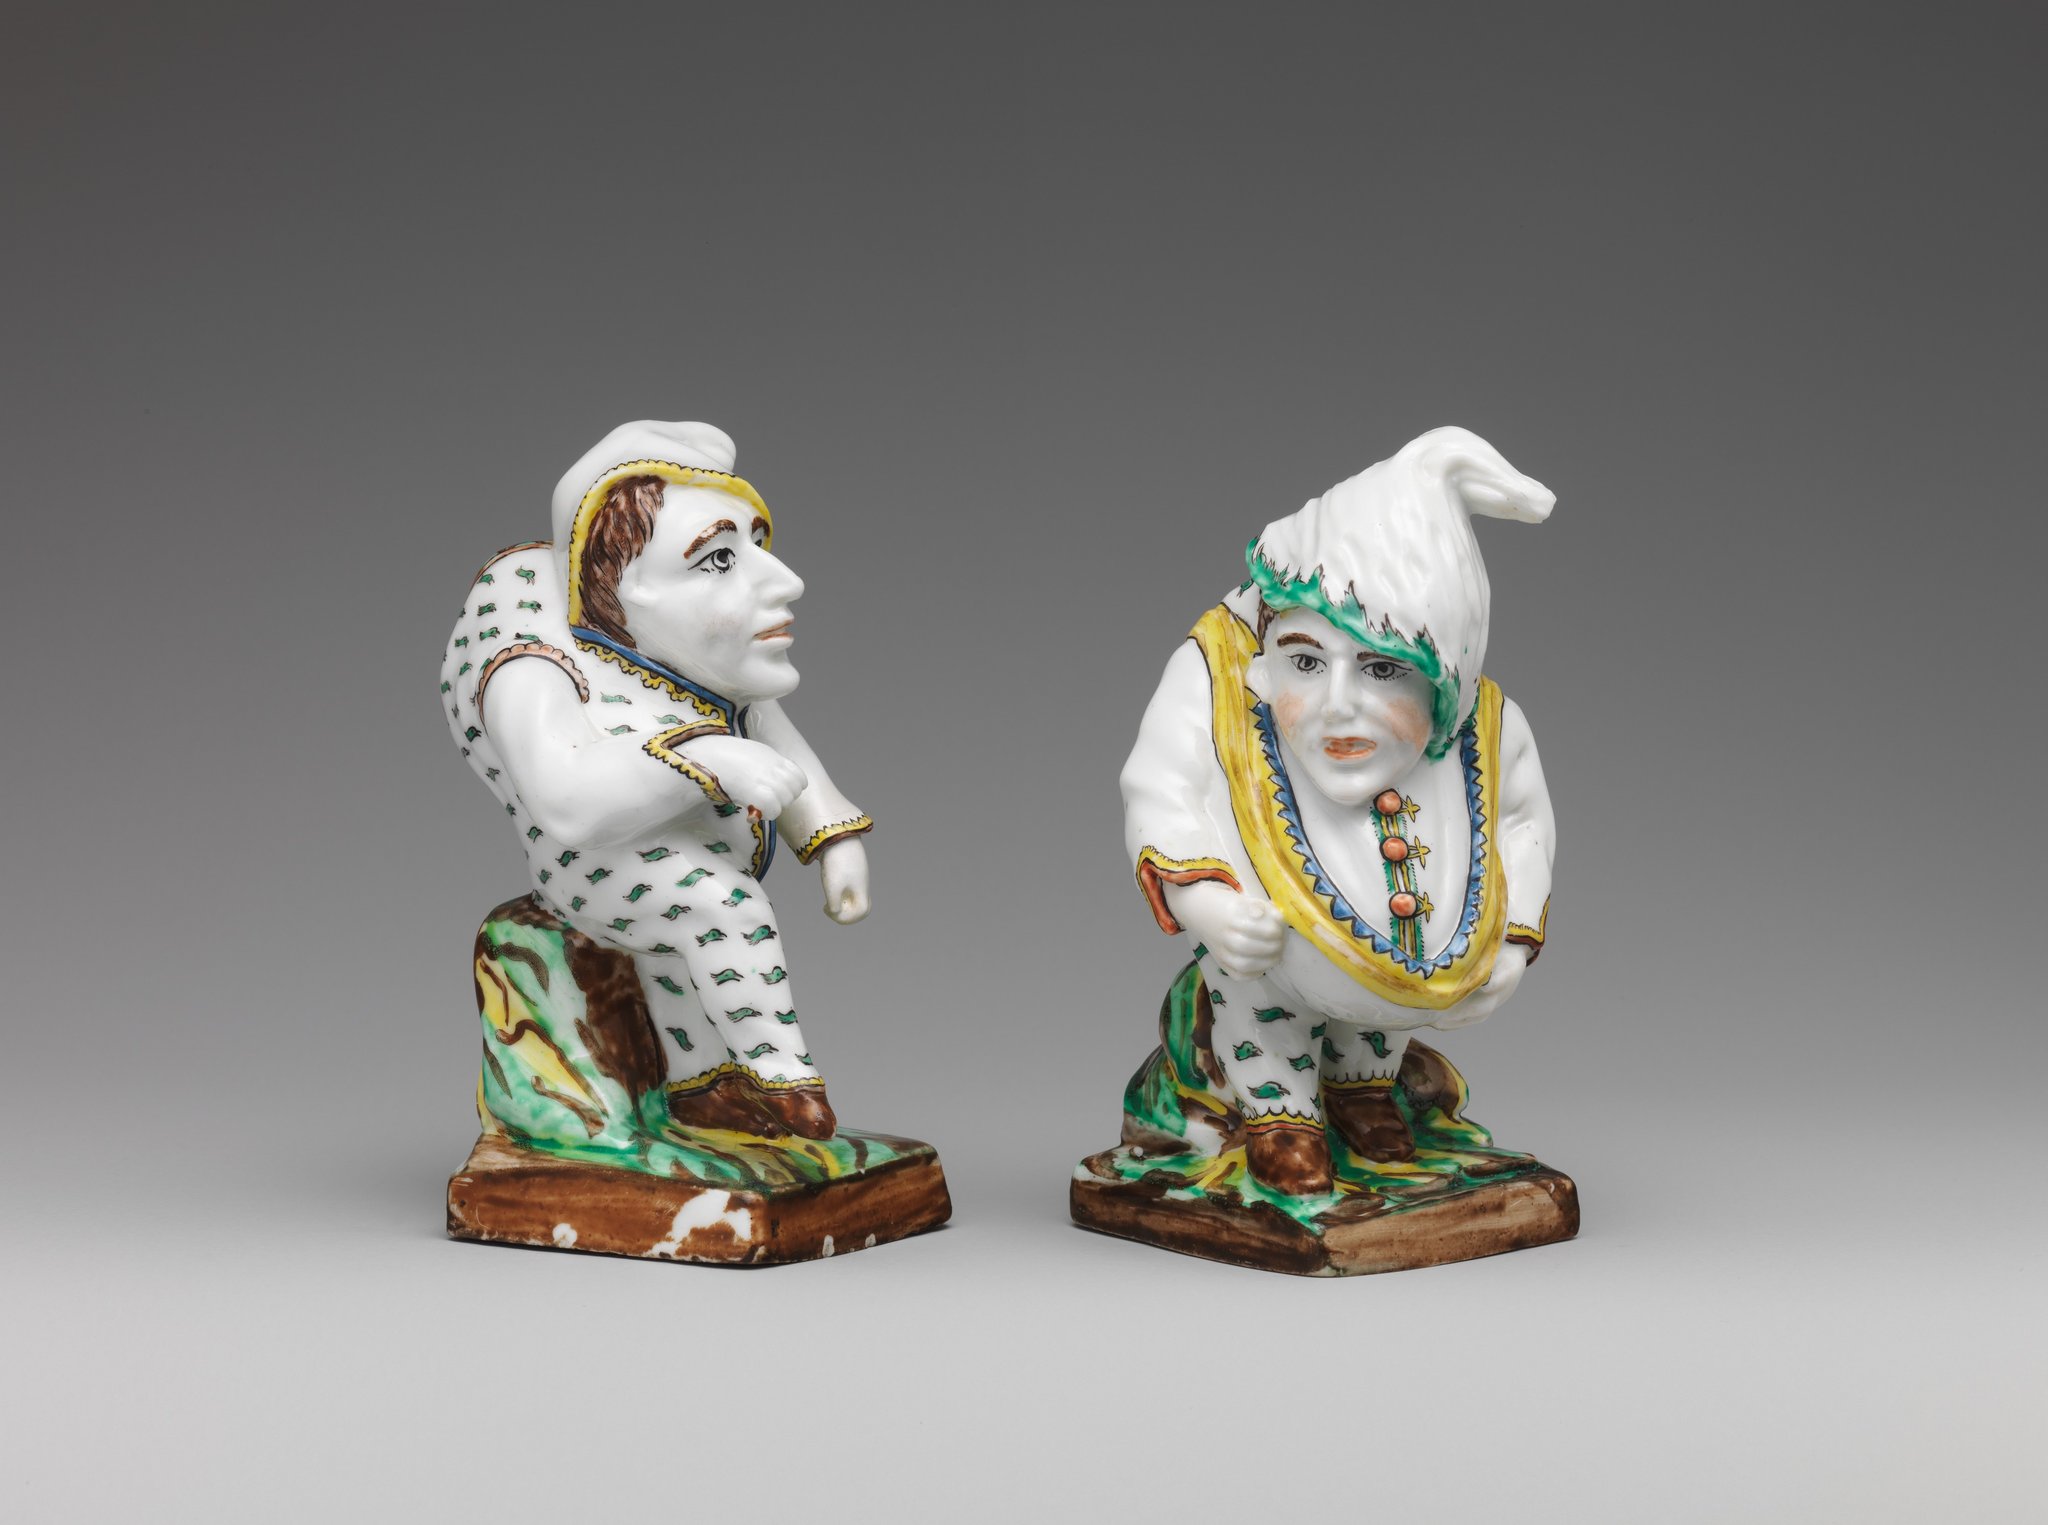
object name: figure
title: Dwarf (one of a pair)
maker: villeroy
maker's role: manufactory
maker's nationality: french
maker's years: 1734-1748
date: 1740-1745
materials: enamel, soft paste porcelain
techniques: polychrome, glazing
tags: men